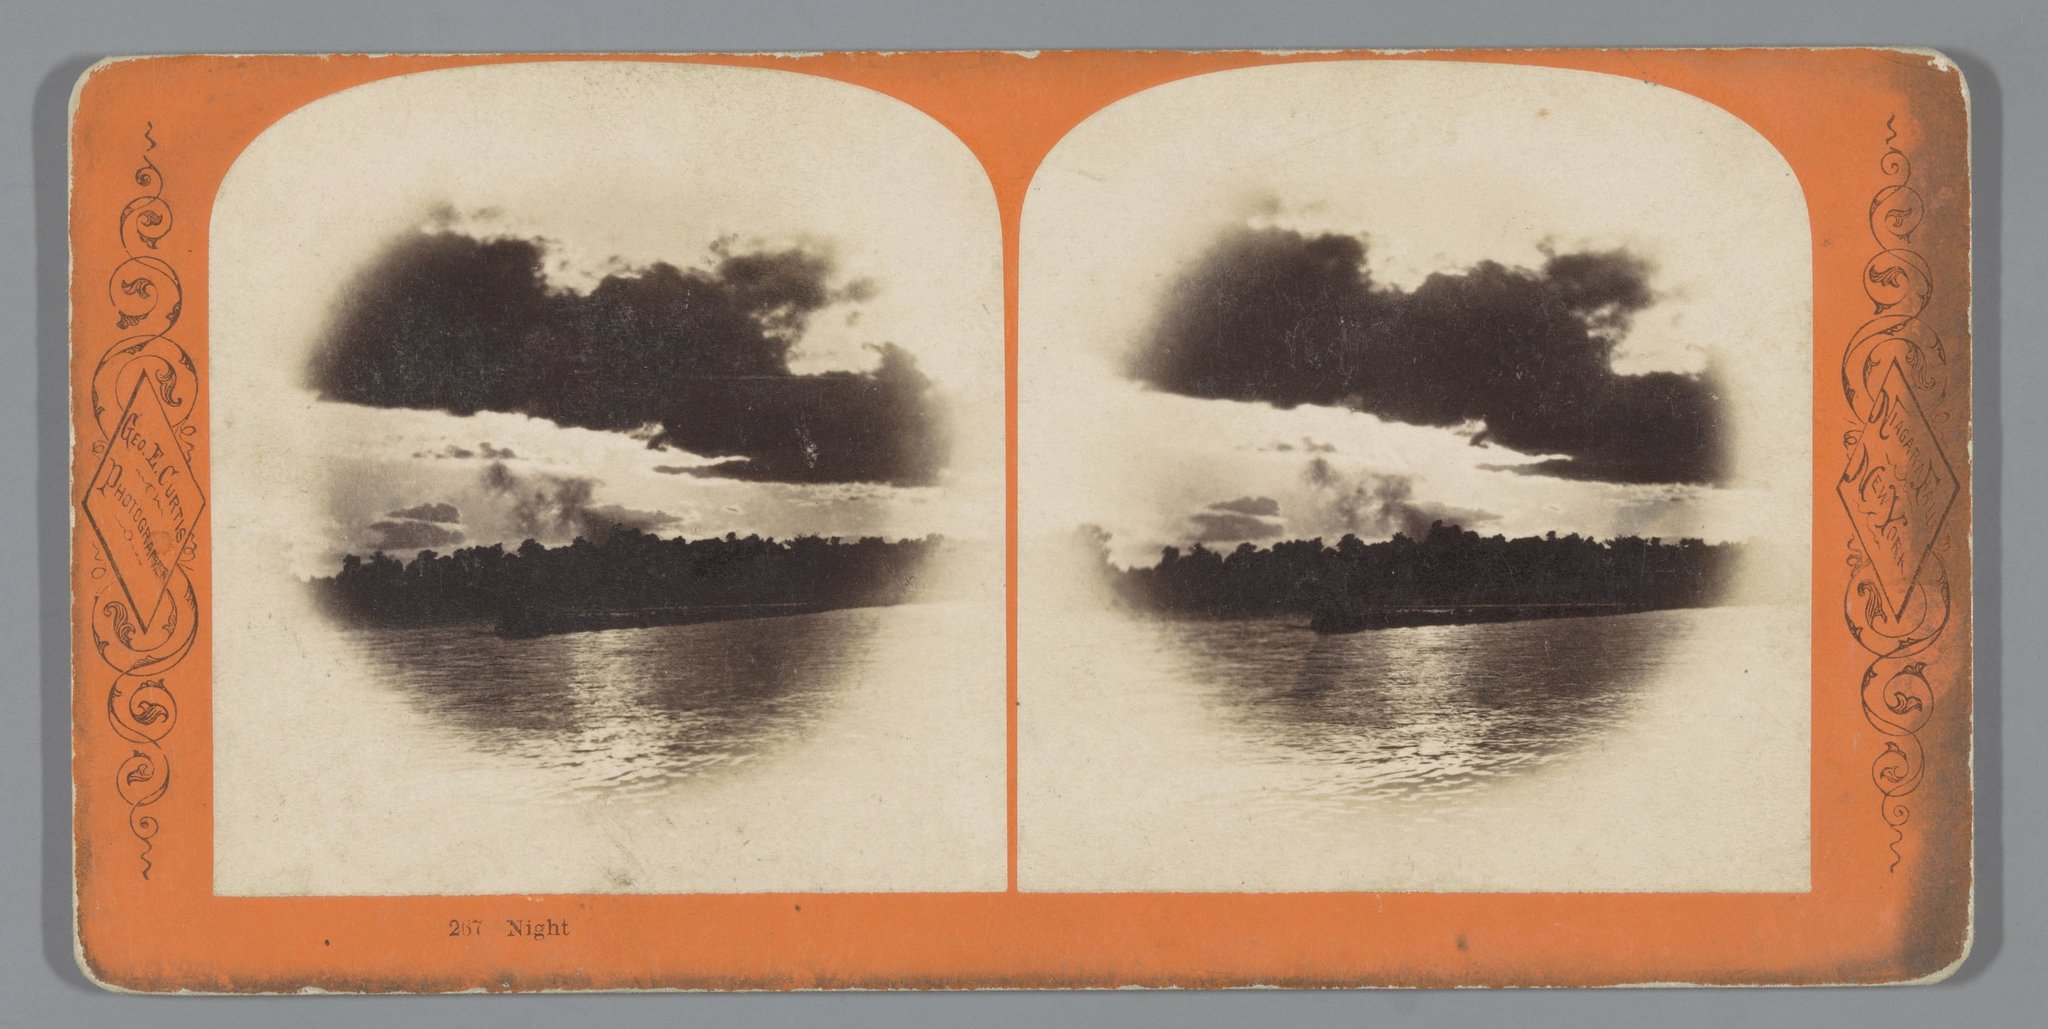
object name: stereograph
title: Night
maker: george e. curtis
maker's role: fotograaf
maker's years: 1830-1910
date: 1866-1910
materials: cardboard, paper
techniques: albumen print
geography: niagara falls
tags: night, reflection (light in general)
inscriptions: number: ‘267’